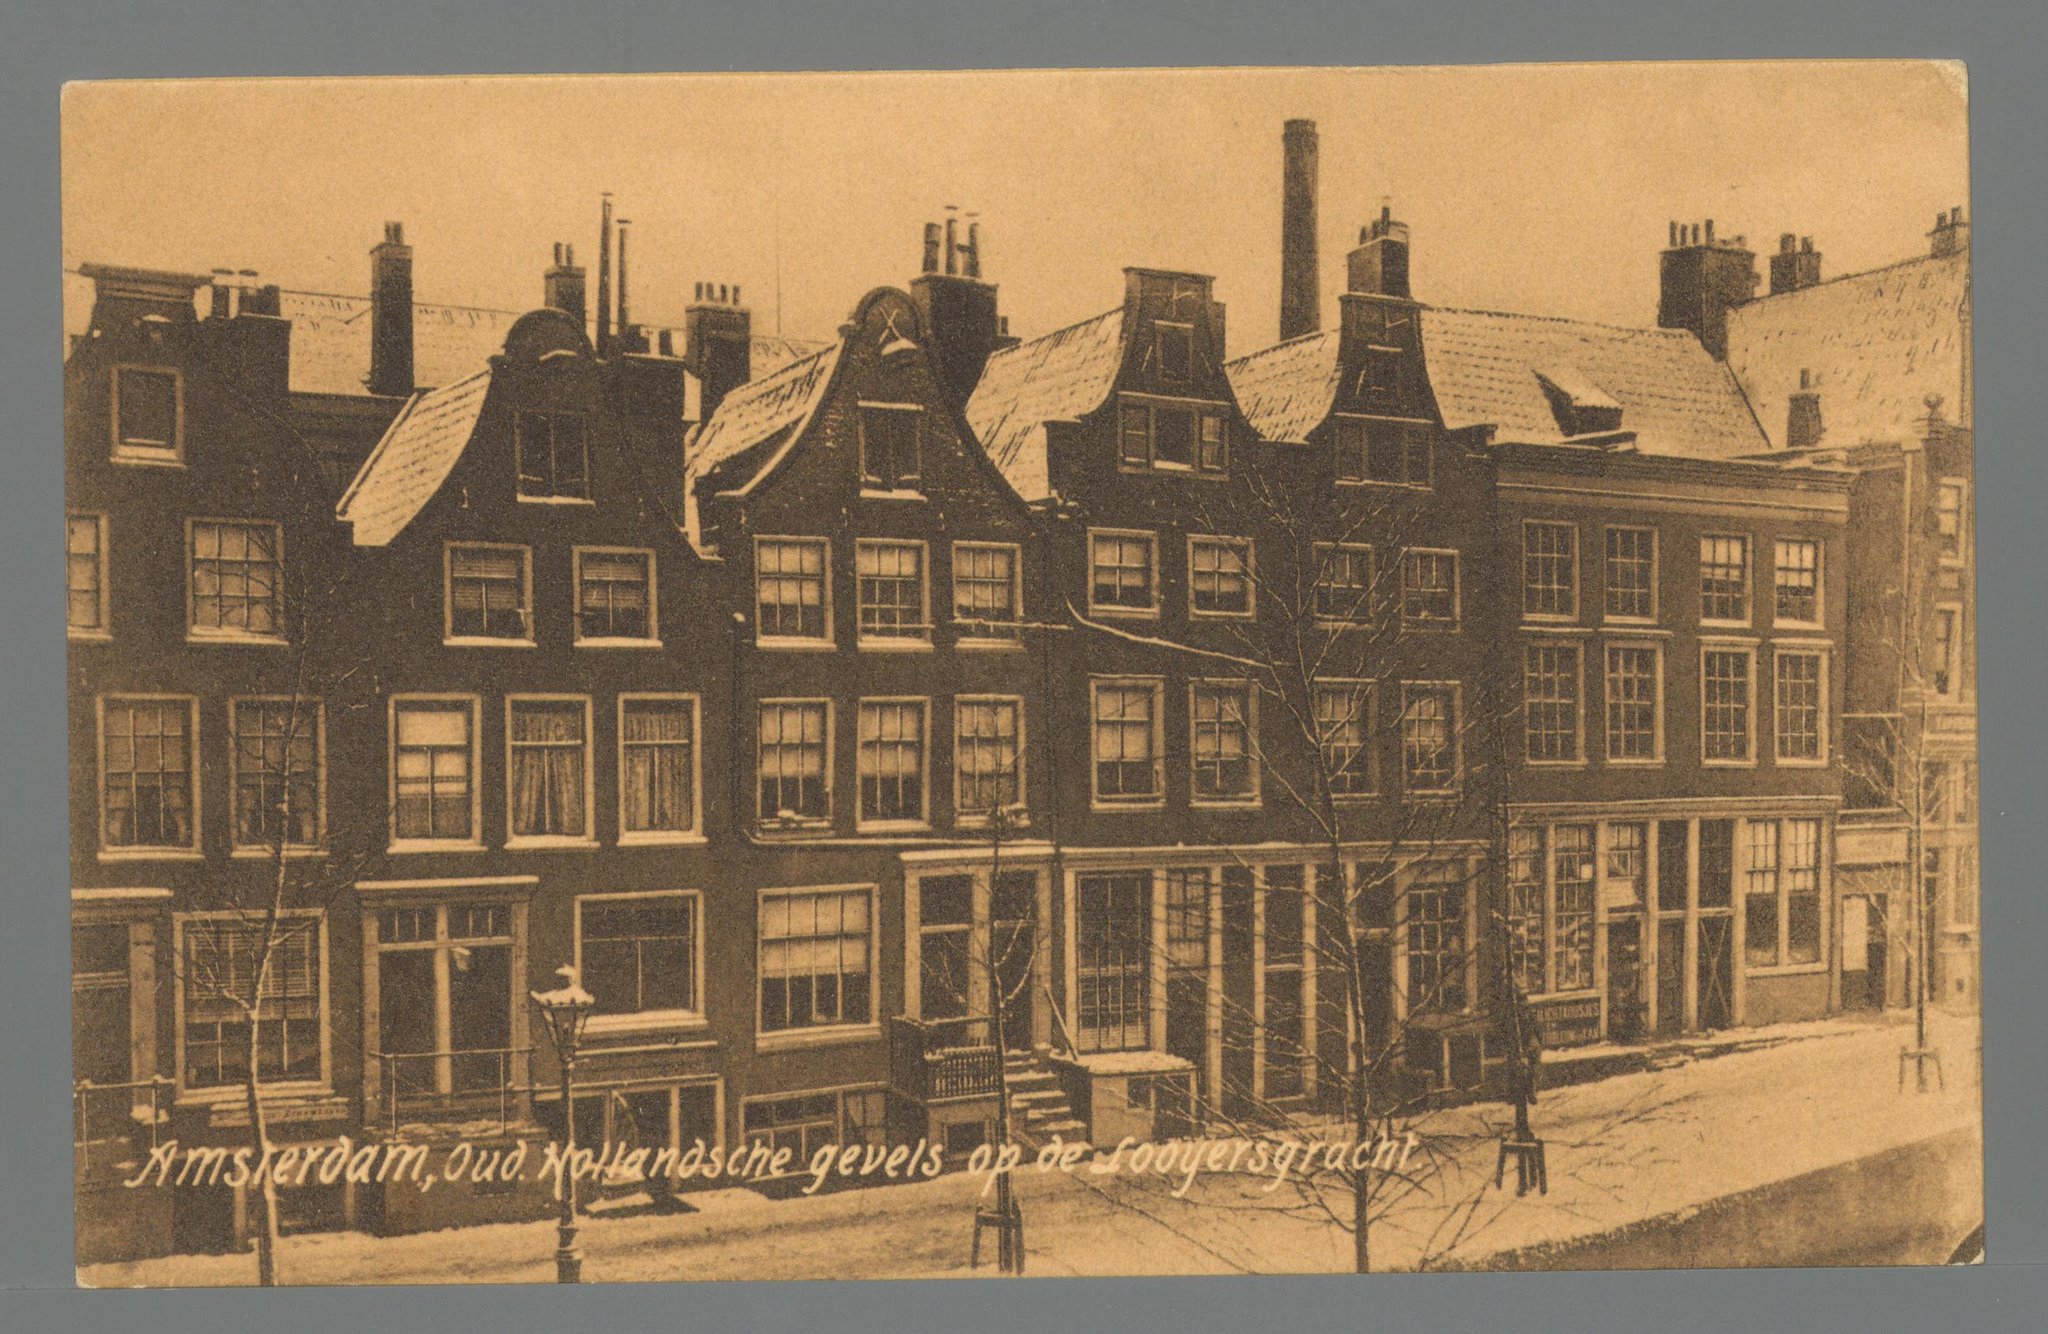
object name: ansichtkaart, prentbriefkaart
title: Amsterdam, Oud. Hollandsche gevels op de Looyersgracht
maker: Anonymous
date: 1906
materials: cardboard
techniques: photograph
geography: amsterdam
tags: city-view, and landscape with man-made constructions, street